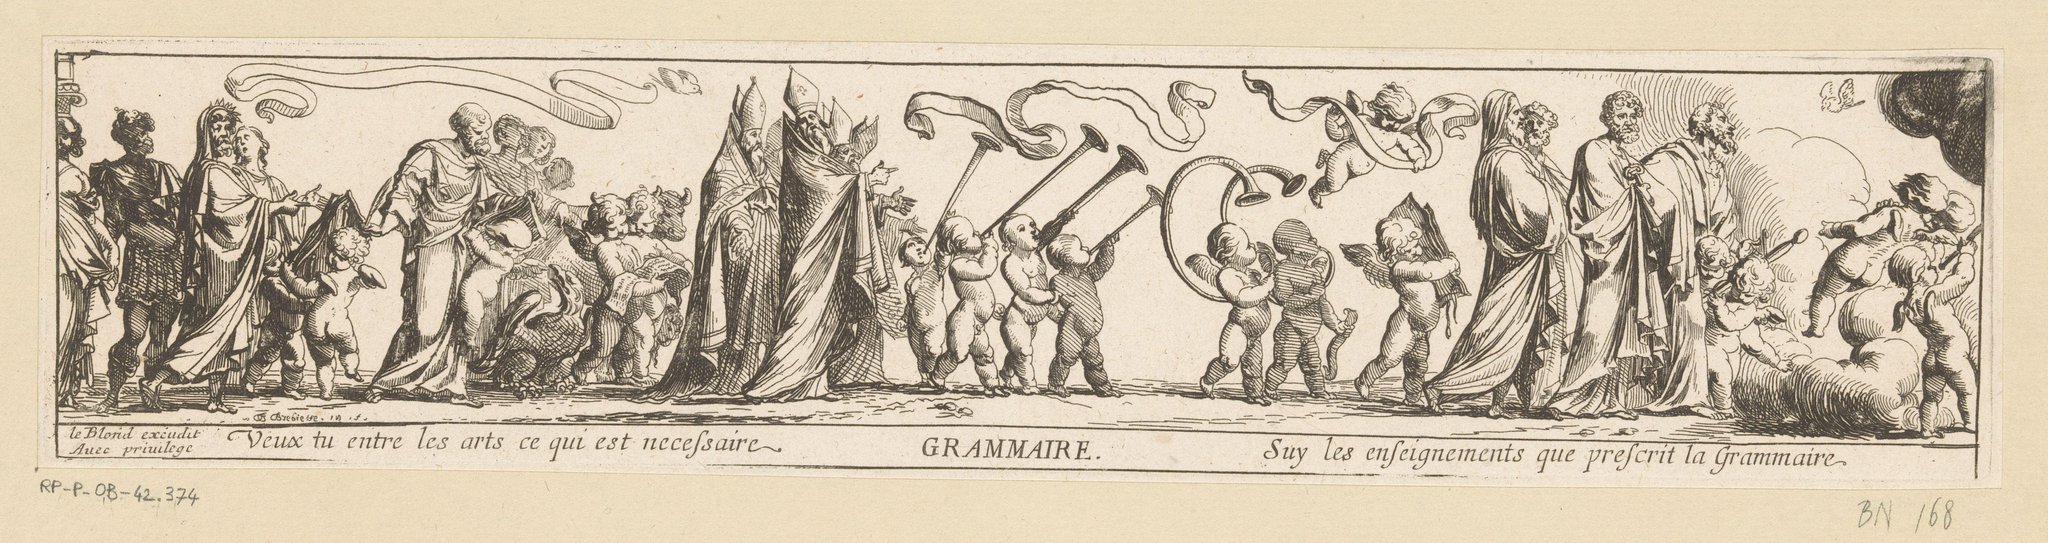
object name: print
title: Personificaties van de kunsten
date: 1608-1650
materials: paper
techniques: etching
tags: the liberal arts, 'artes liberales', 'grammatica' (~ trivium); 'grammatica' (ripa), triumphs (allegorical and symbolic)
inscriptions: collector's mark: Lugt 240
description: Maakt deel uit van een serie van vier prenten met personificaties van de kunsten.